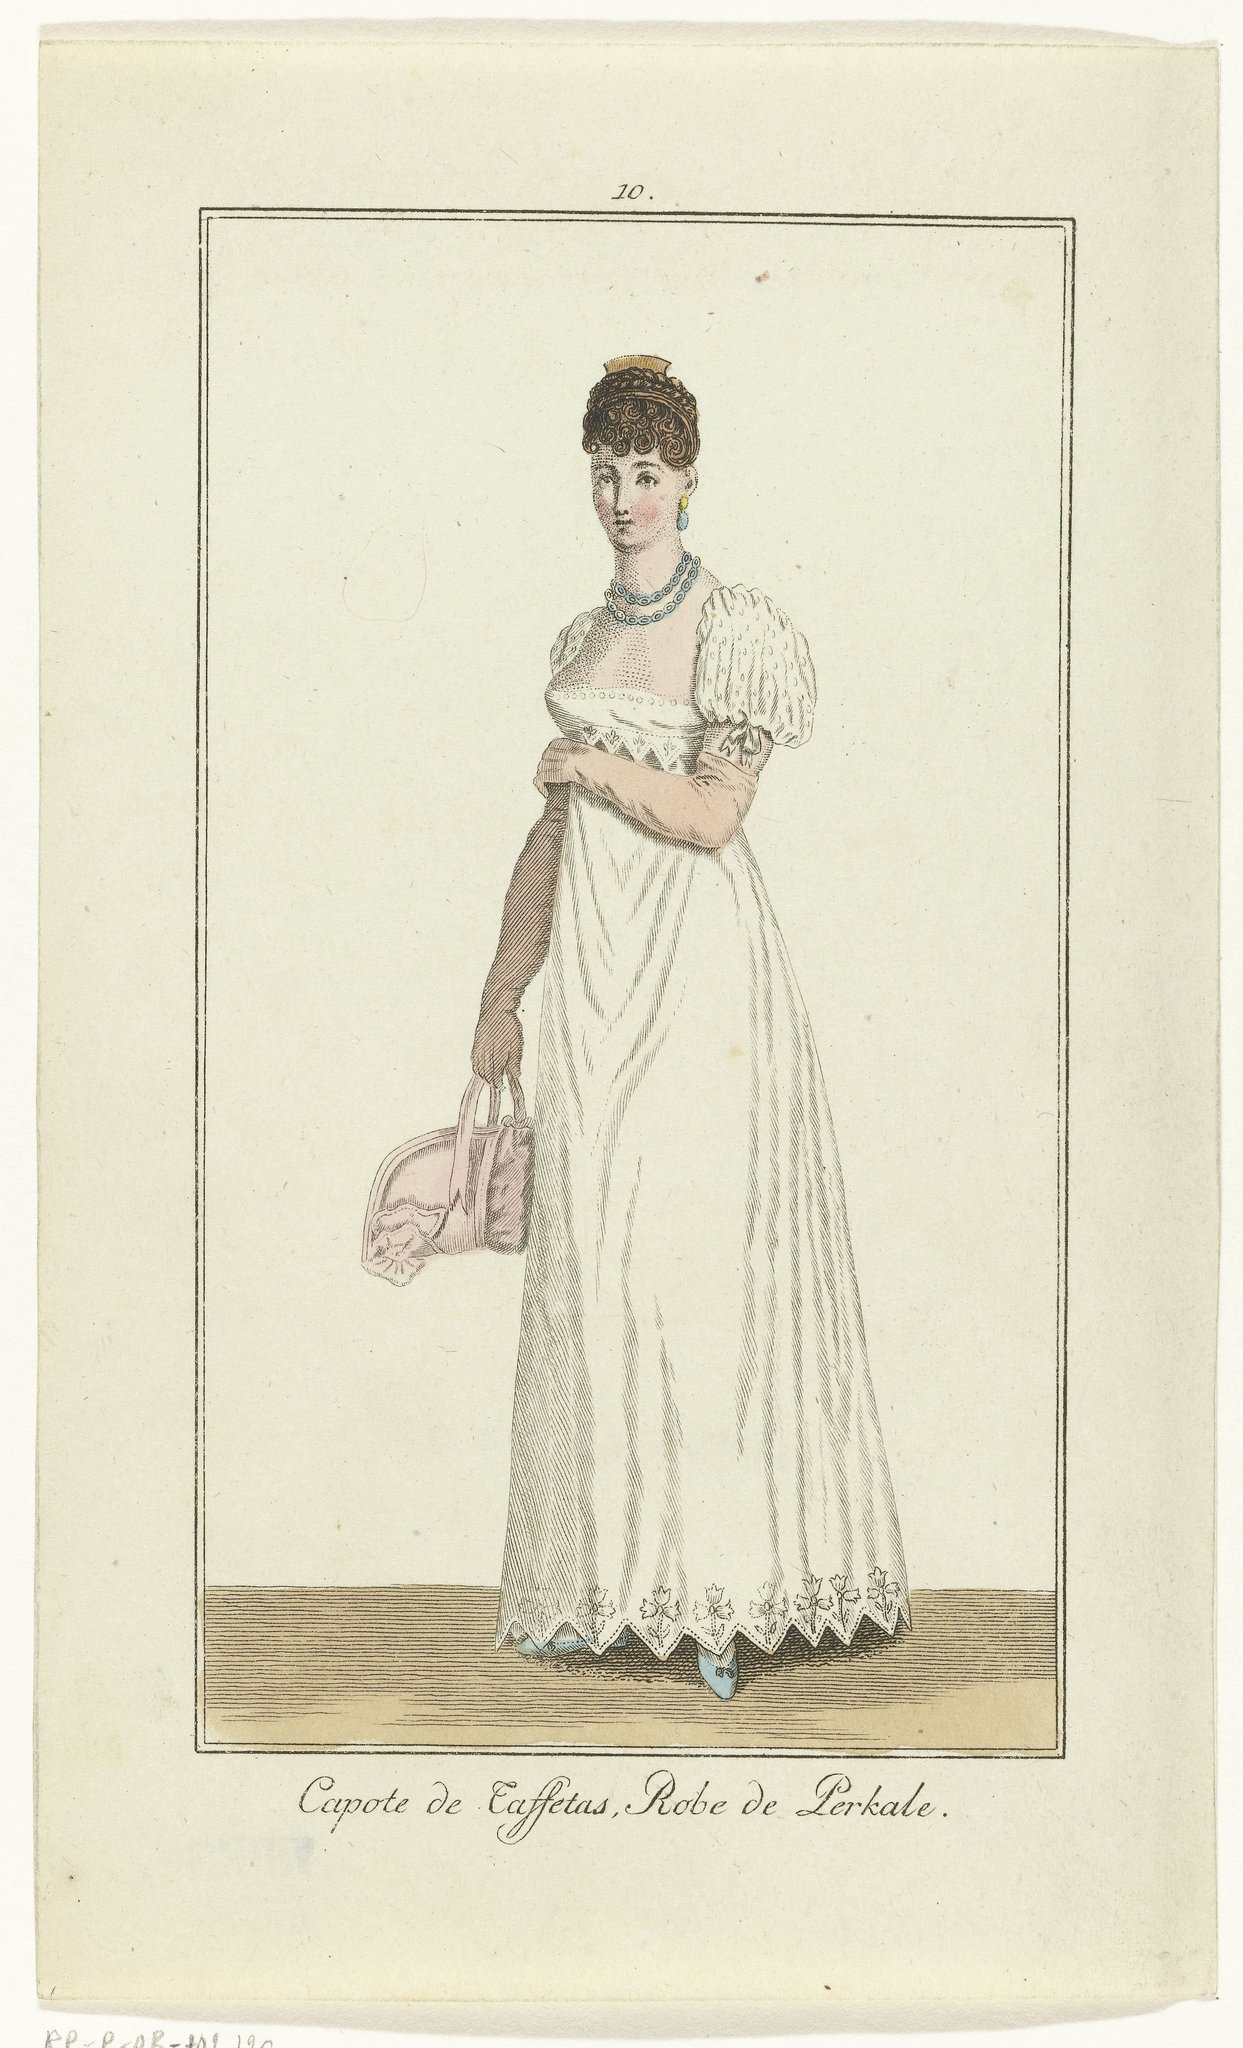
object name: fashion print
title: Elegantia, of tijdschrift van mode, luxe en smaak voor dames, Mei 1807, No. 10 : Capote de Taffetas,...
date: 1807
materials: paper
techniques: engraving, hand coloring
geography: amsterdam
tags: head-gear (capote) (+ women's clothes), gloves, mittens (long gloves) (+ women's clothes), fashion plates, dress, gown (+ women's clothes), necklace (+ women's clothes)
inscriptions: caption: ‘Capote de Caffetas. Robe de Perkale’